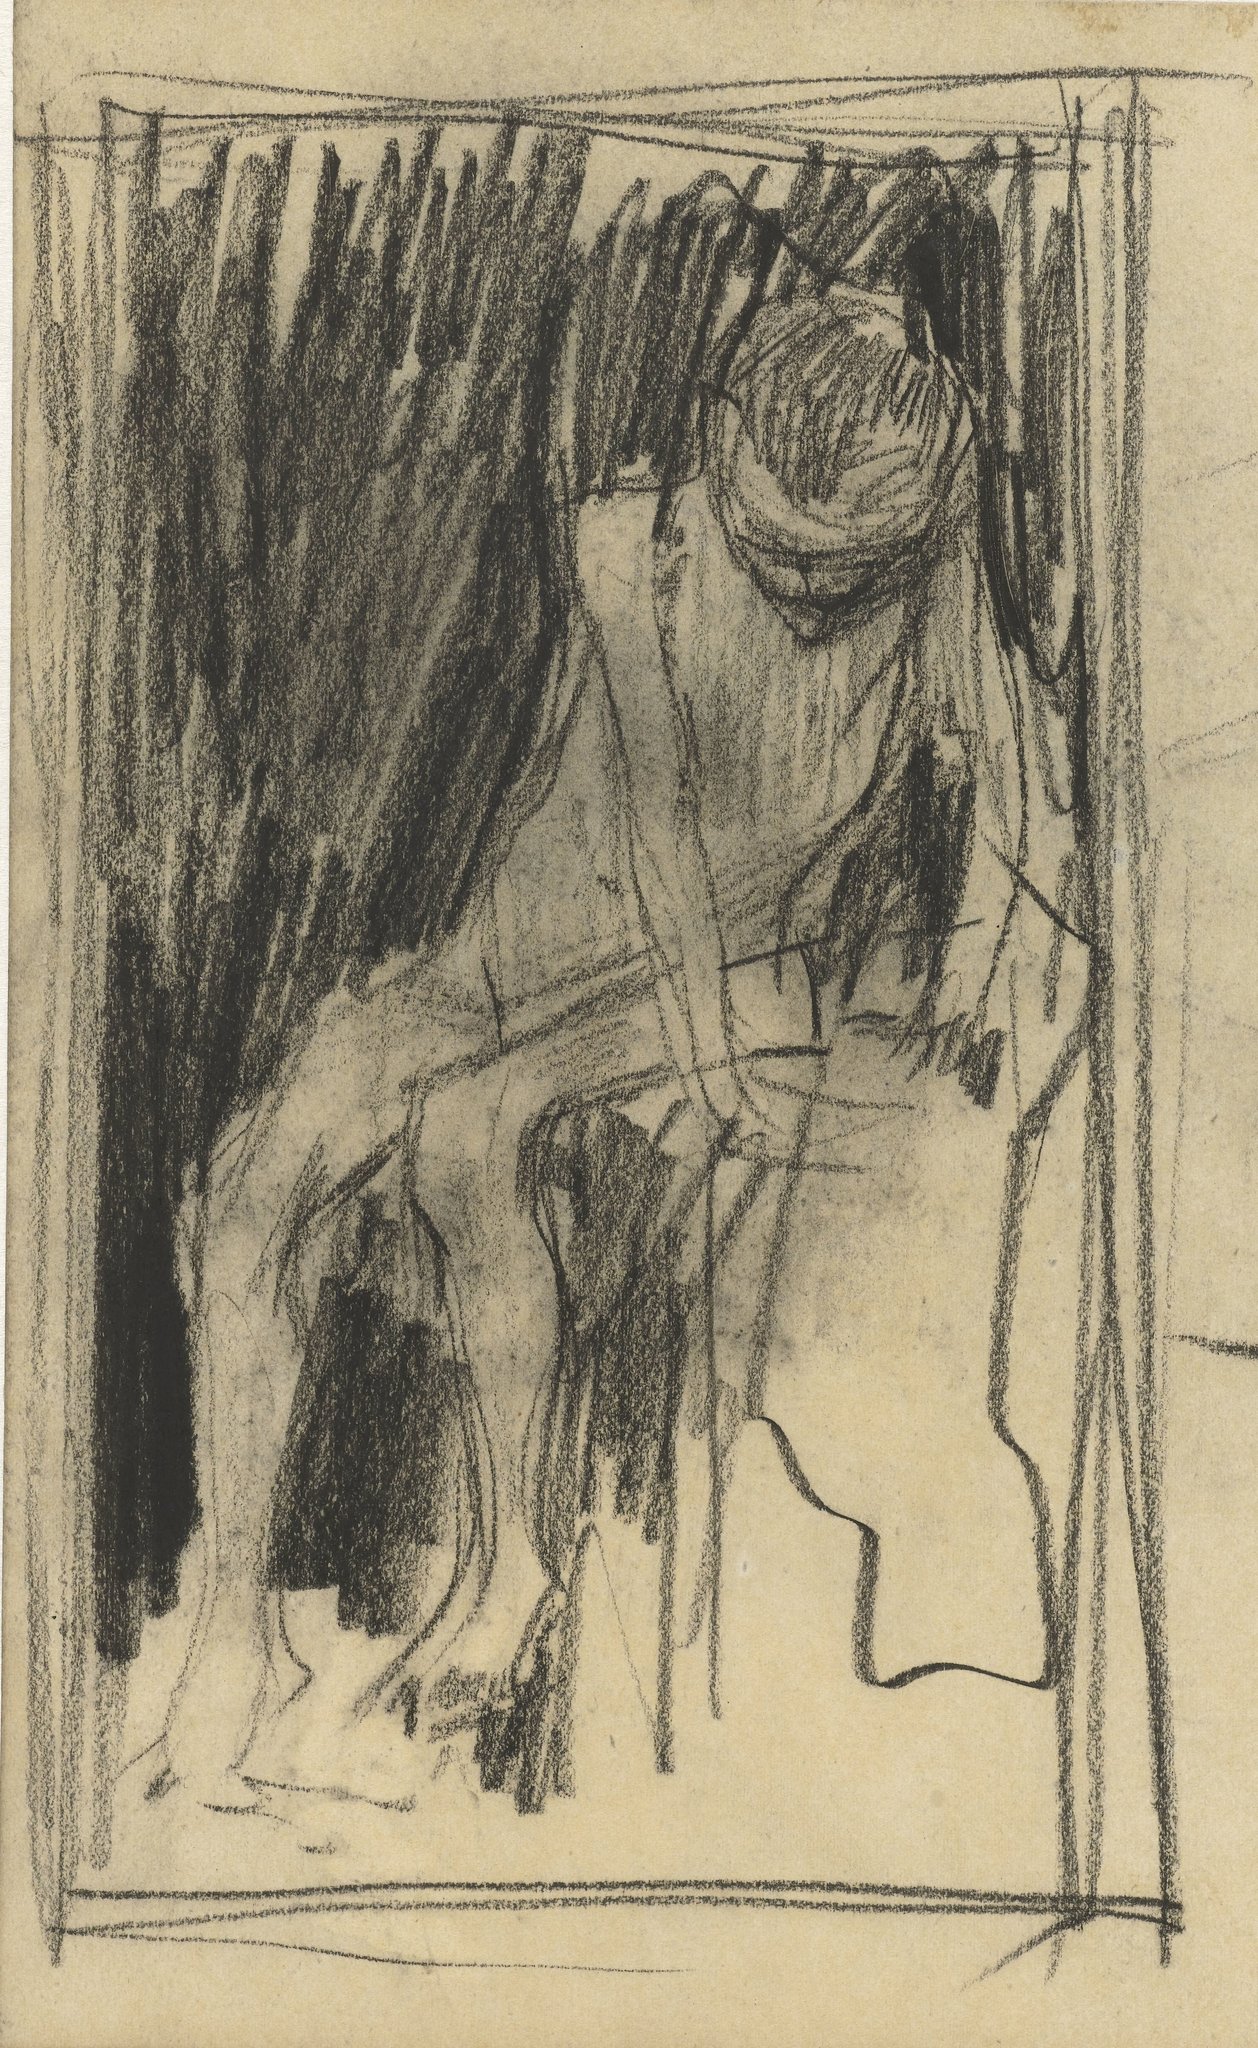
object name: drawing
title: Zittende naakte jongen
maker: marius bauer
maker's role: draughtsman, print maker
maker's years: 1867-1932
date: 1877-1932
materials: chalk, paper